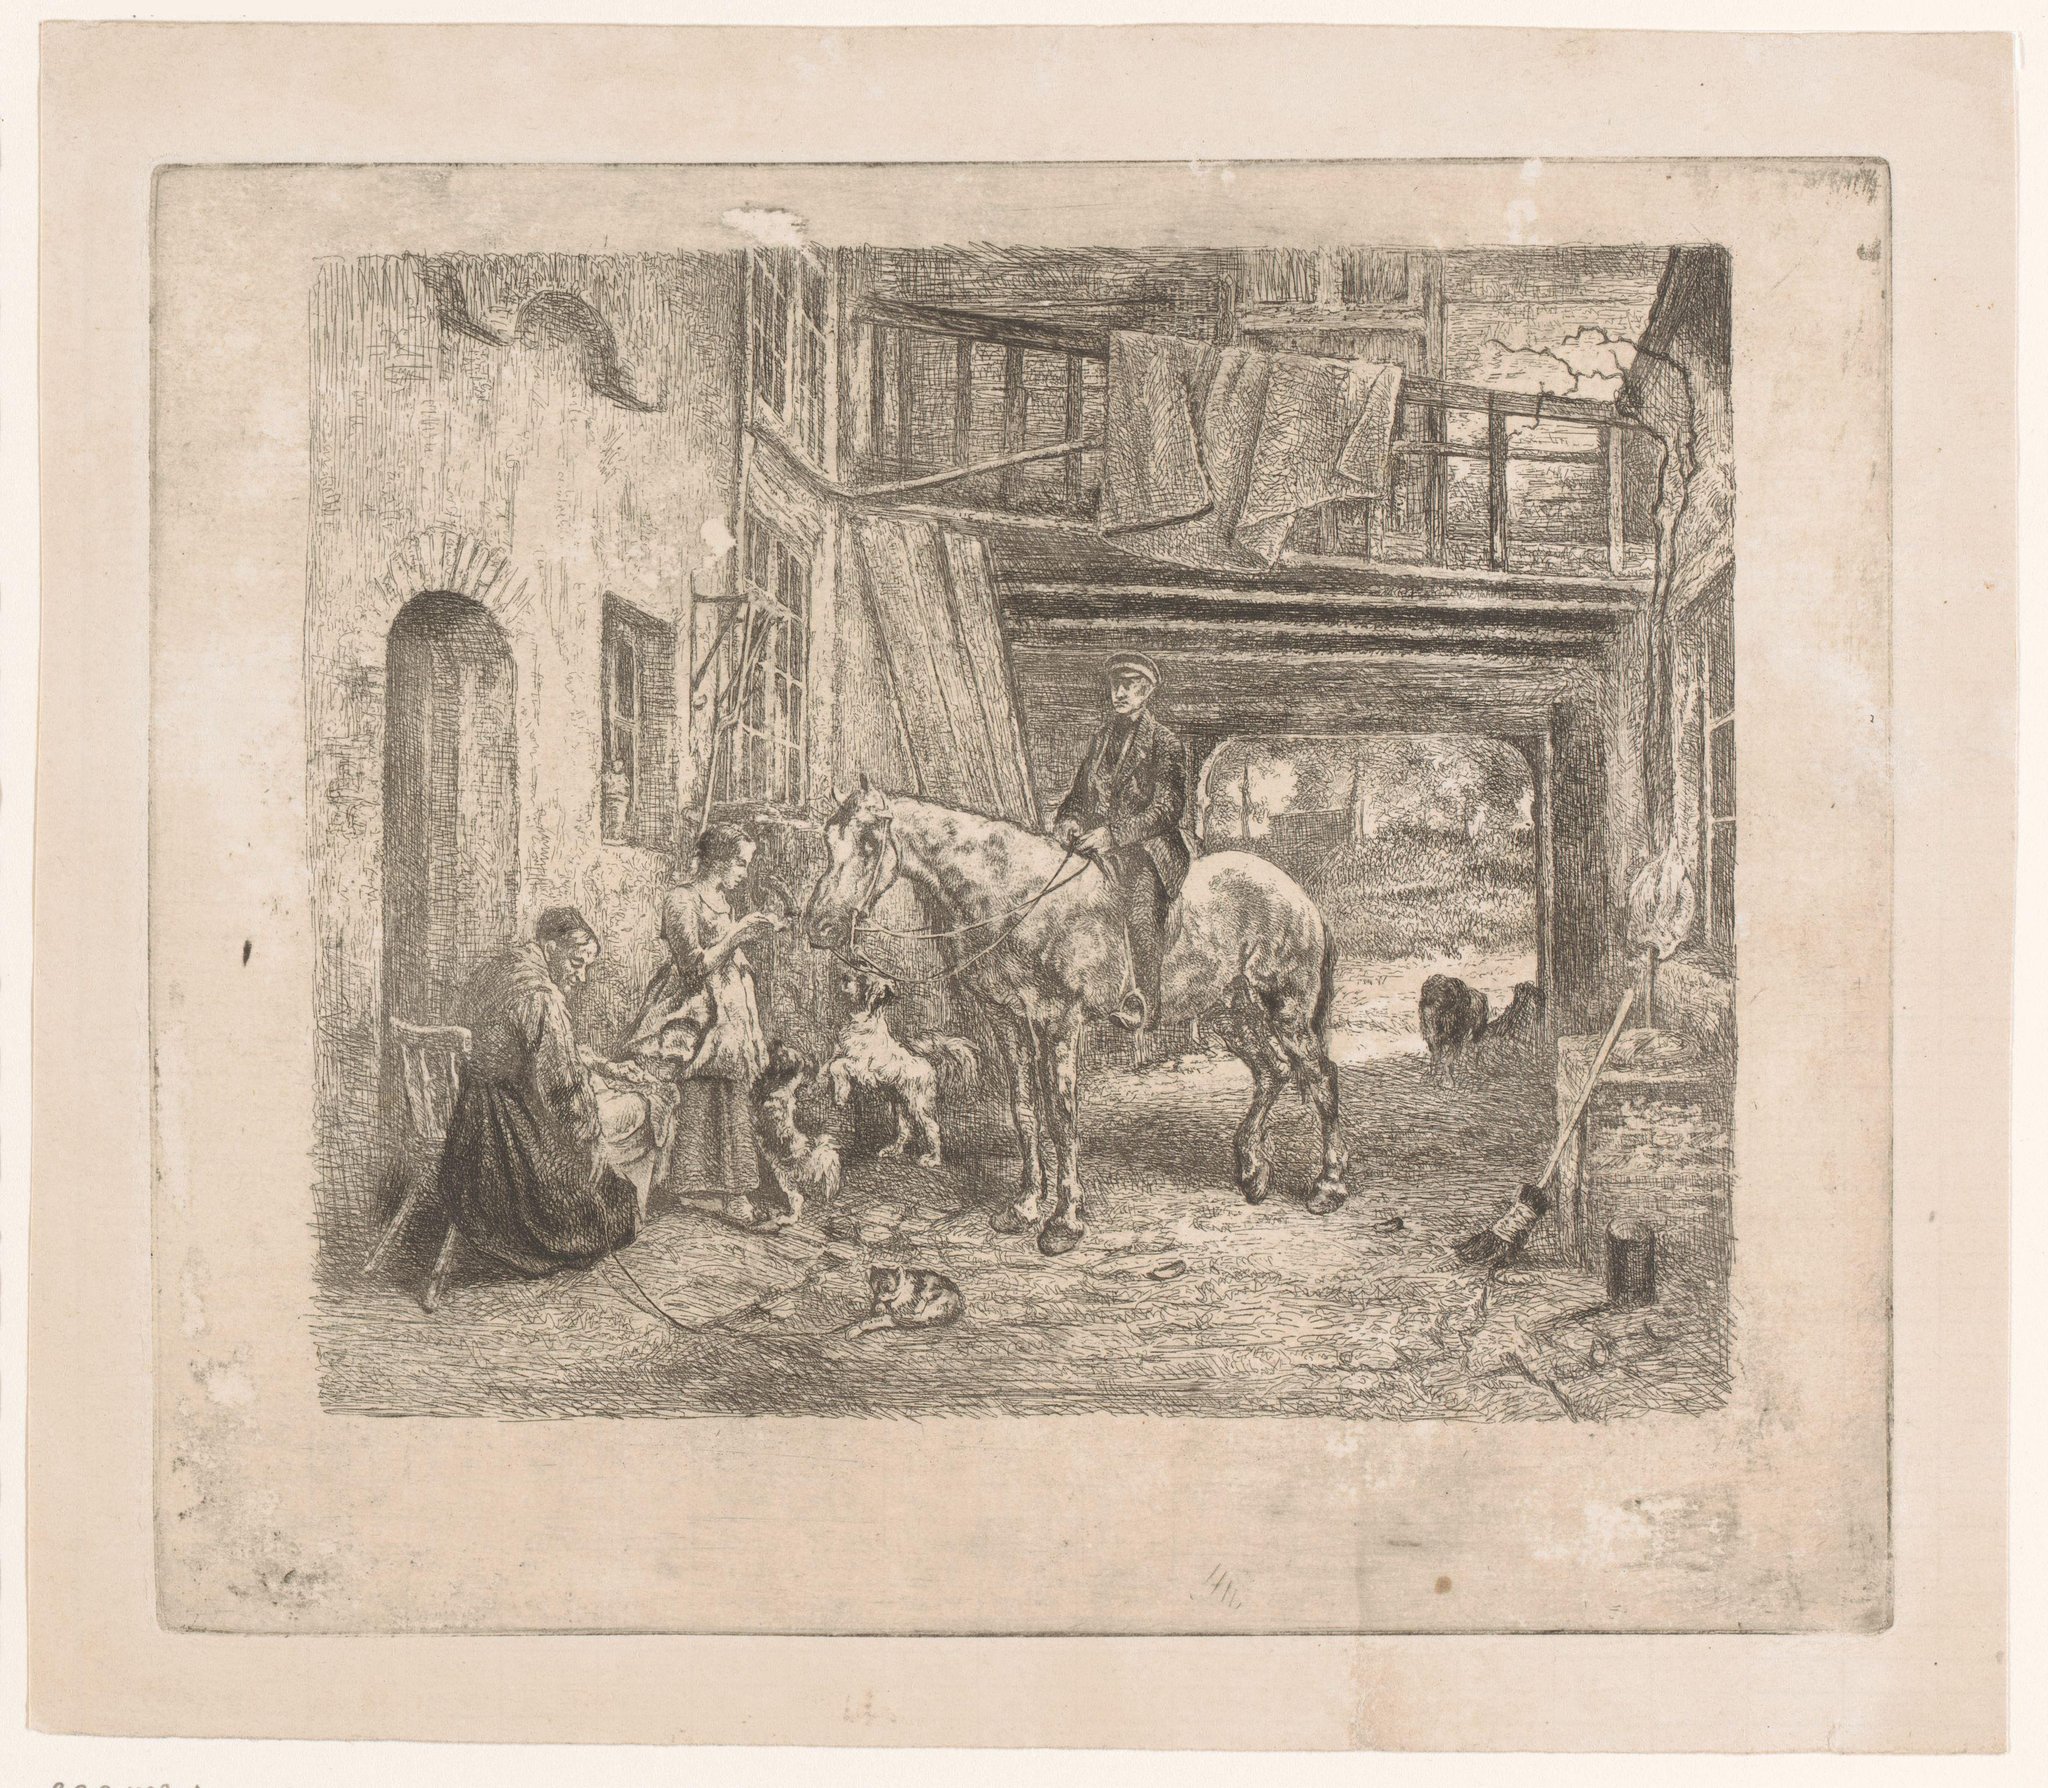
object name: print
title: Binnenplaats met man te paard die een brief bezorgt aan een jonge vrouw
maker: jan stobbaerts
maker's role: draughtsman, print maker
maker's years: 1838-1914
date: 1848-1879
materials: paper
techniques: etching, intaglio, letterpress printing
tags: riding a horse, ass, or mule; rider, horseman, adolescent, young woman, maiden, courtyard, letter, envelope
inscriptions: stamp, collector's mark: Lugt 2228, stamp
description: Mogelijk van hetzelfde blad als RP-P-1890-A-15686 en RP-P-1888-A-13316; de tabellen op de verso's lijken bij elkaar te horen.